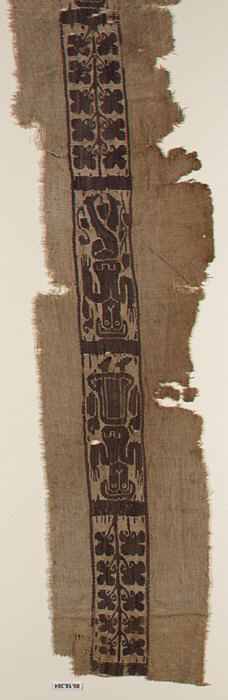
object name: textile fragment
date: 301-400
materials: linen, wool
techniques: weave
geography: egypt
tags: human figures